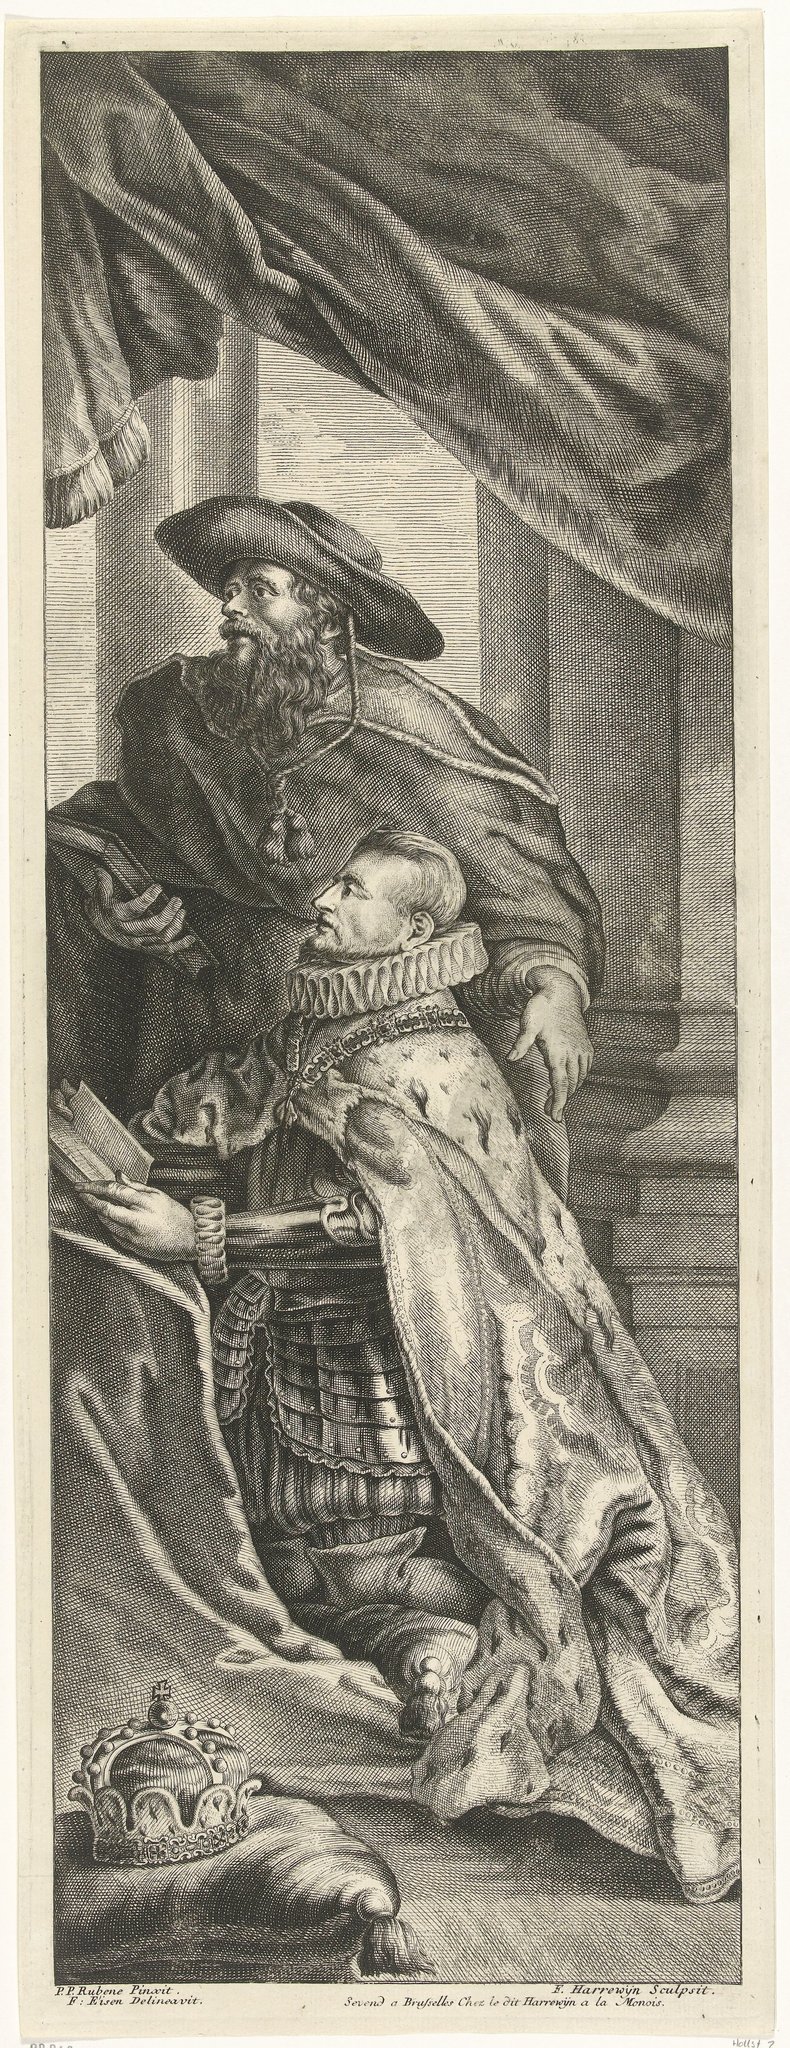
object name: print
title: Portret van Albrecht, aartshertog van Oostenrijk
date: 1710-1764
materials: paper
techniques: engraving, etching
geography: brussels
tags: brussels, albrecht aartshertog van oostenrijk, neck-gear ~ clothing (with name) (+ men's clothes), coat (+ men's clothes), head-gear: hat (+ men's clothes), knighthood order of the golden fleece - insignia of a knighthood order, e.g.: badge, chain (with name of order), the (nude) human figure; 'corpo humano' (ripa) (+ kneeling), insignia and symbols of sovereignty (crown, diadem, sceptre, orb, seal, standard, cloak, pectoral)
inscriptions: collector's mark: Lugt 240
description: Kopie in spiegelbeeld naar het linker deel van het triptiek van het Heilige lldefonsus-altaar door Peter Paul Rubens, thans in het Kunsthistorisches Museum te Wenen, inv.nr. GG678.